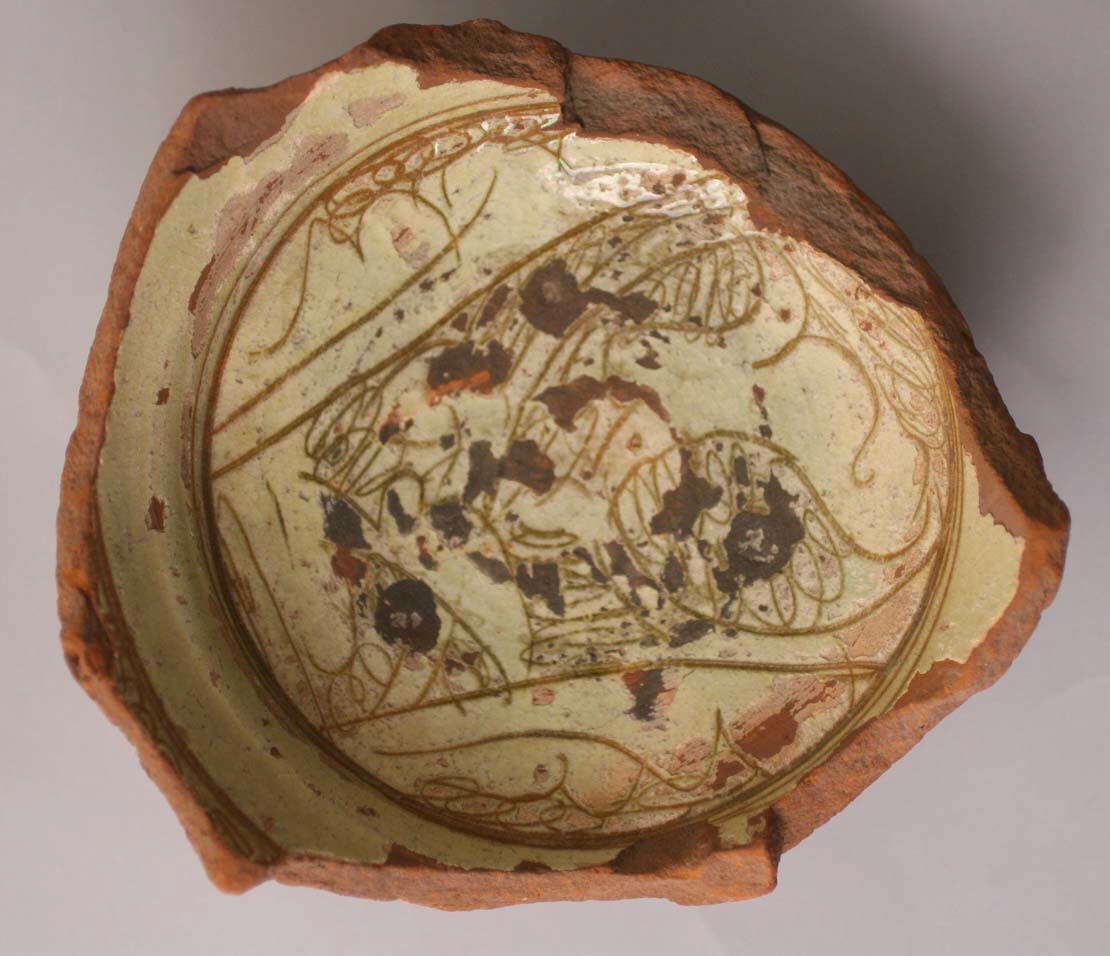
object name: ceramic fragment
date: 1301-1500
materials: earthenware, glaze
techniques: coloring, incising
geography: egypt